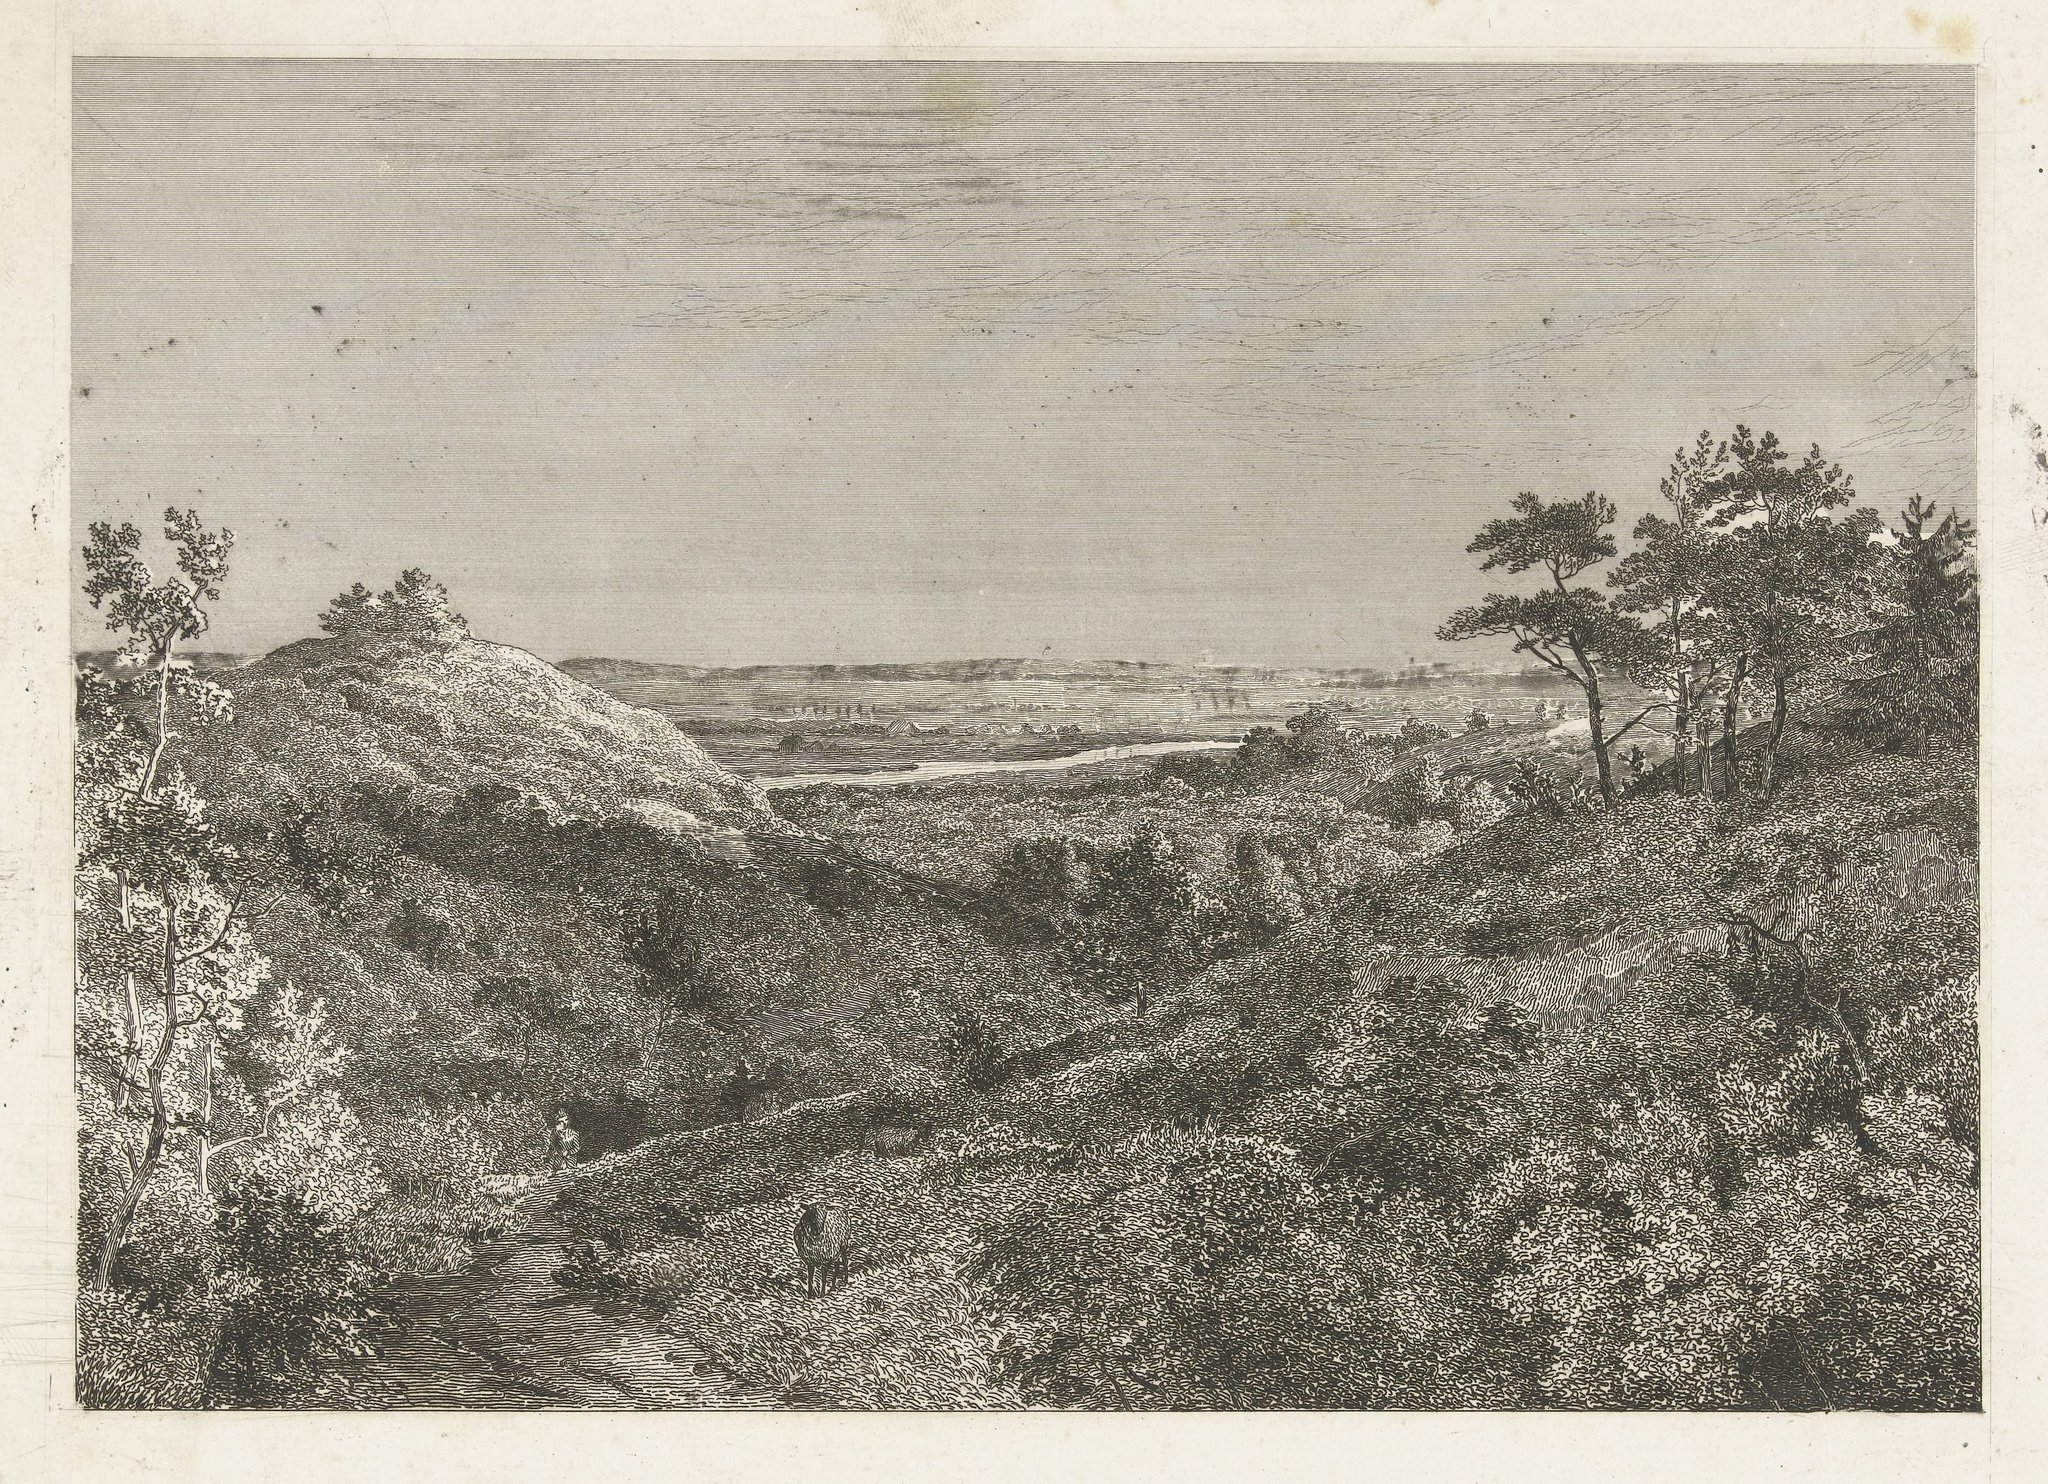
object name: print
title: Gezicht op een beekdal bij Doorwerth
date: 1838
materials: paper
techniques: engraving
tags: dale, valley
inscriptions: collector's mark: Lugt 2228